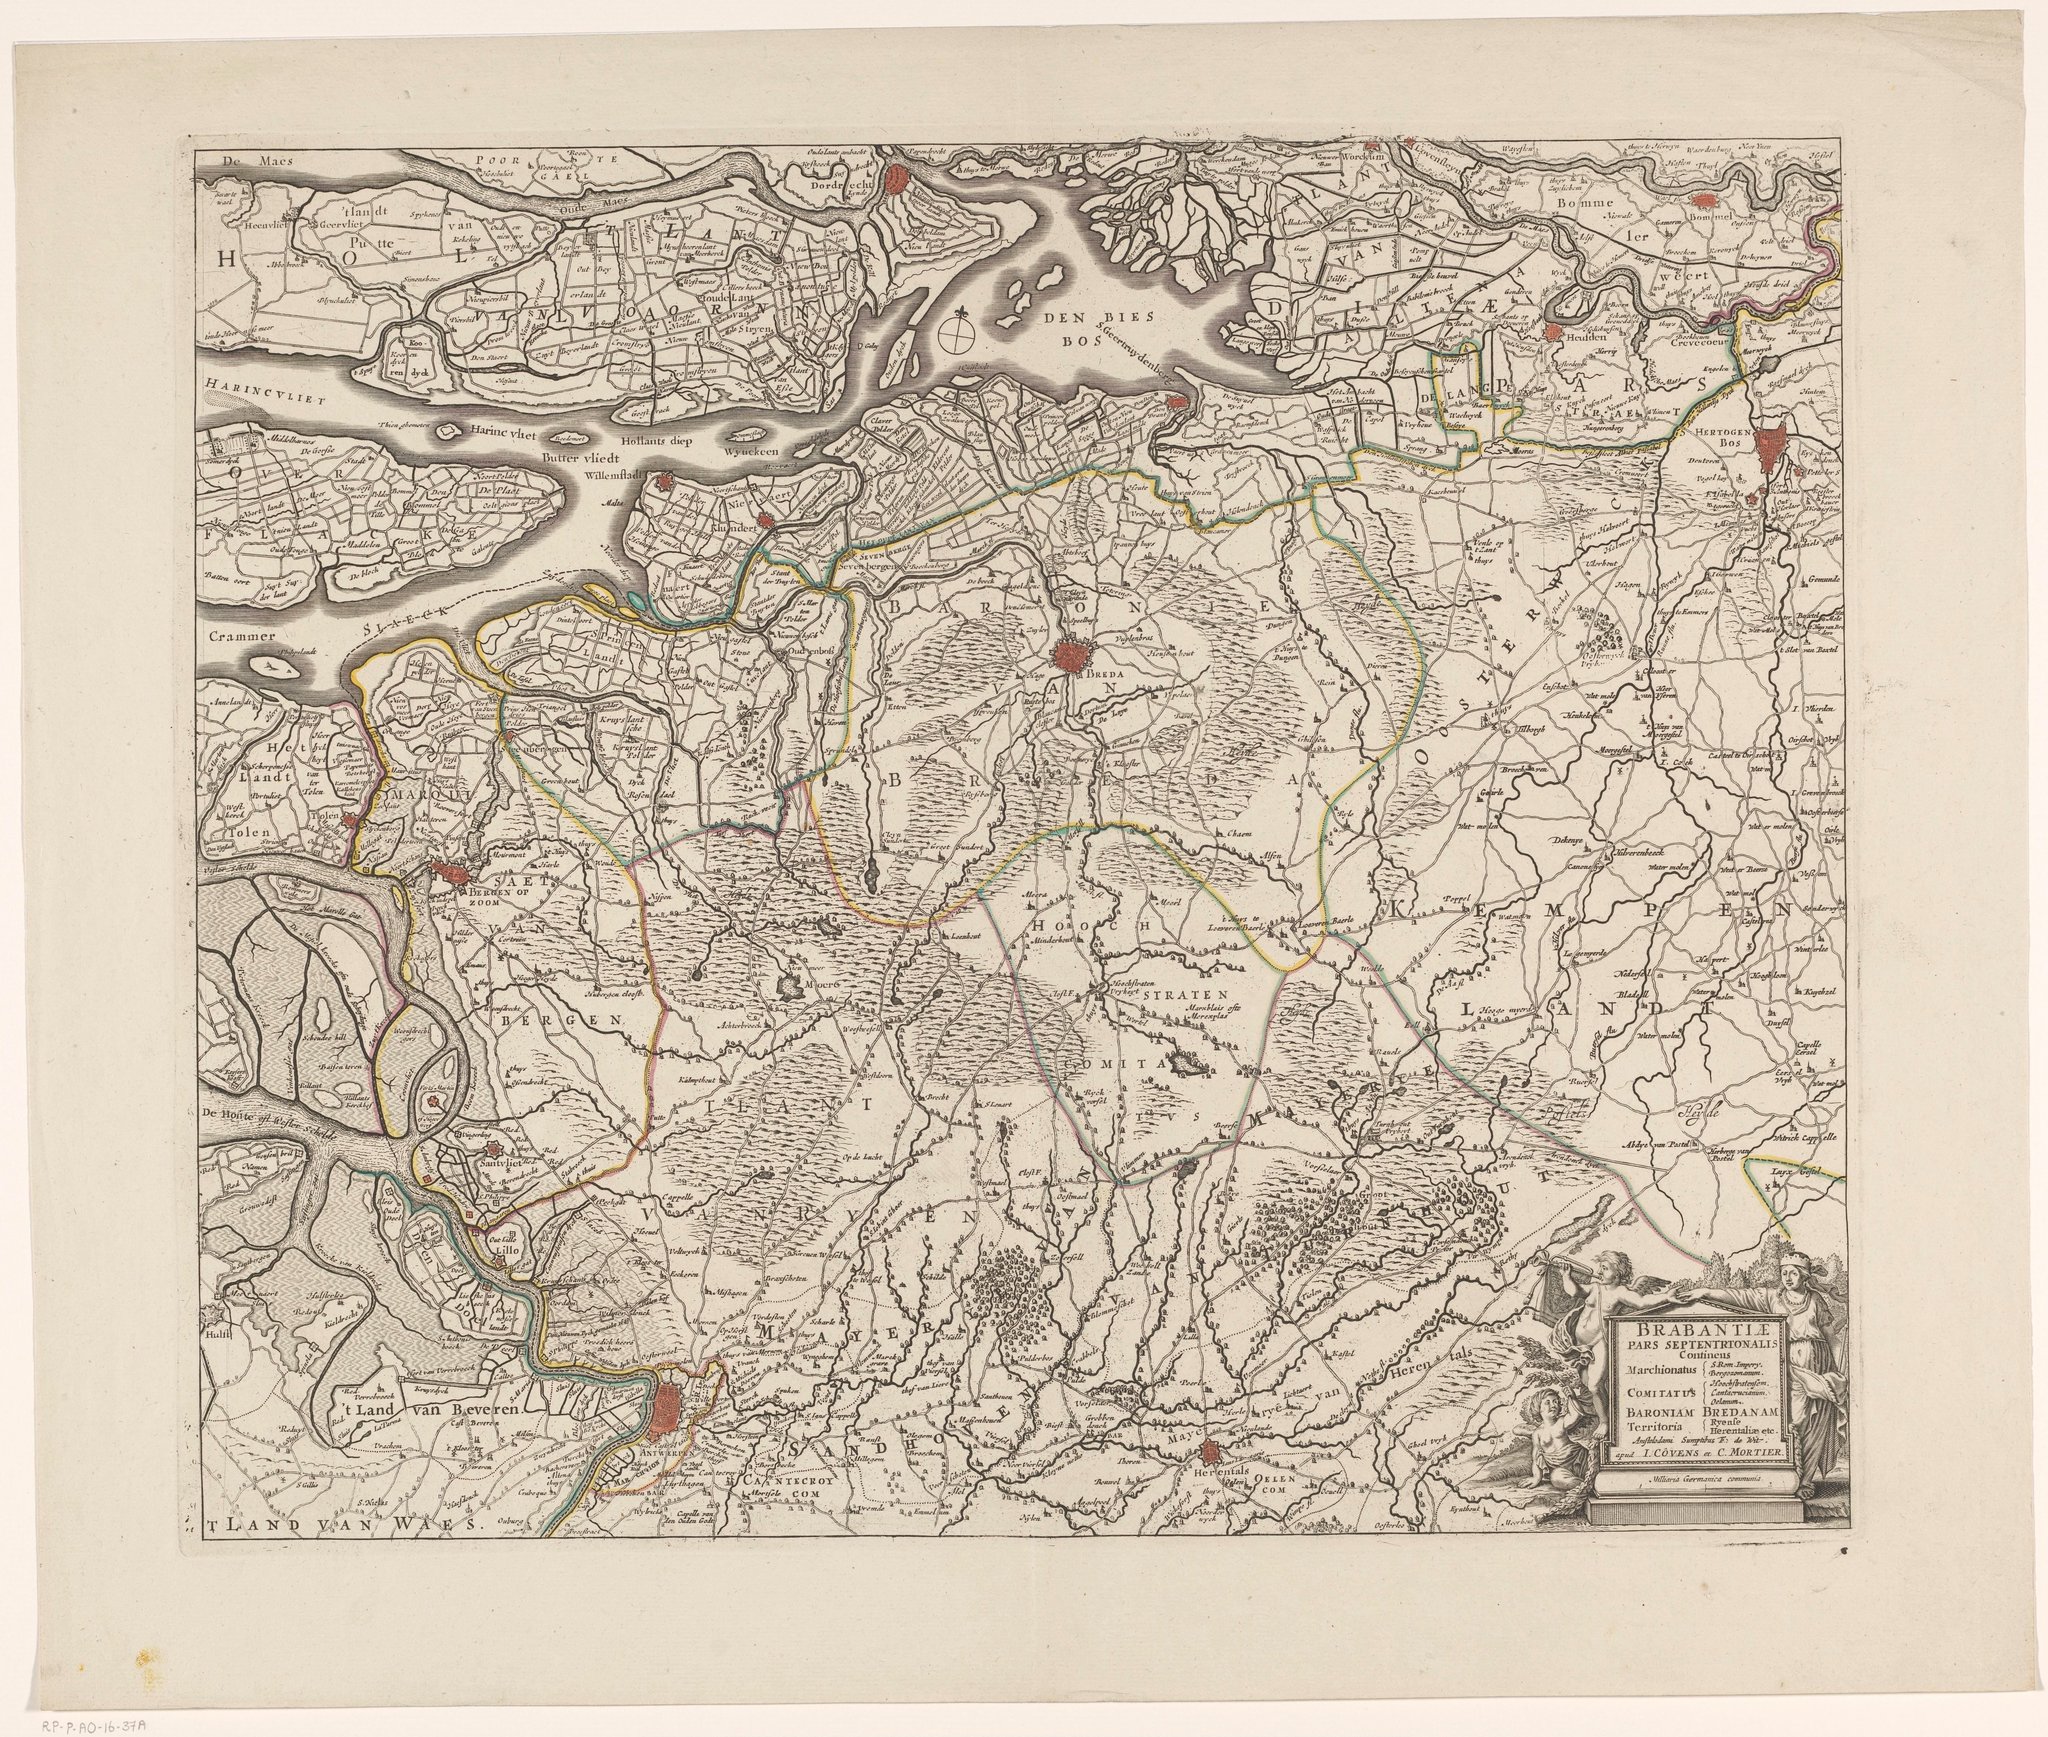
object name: print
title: Brabantiae pars septentrionalis continens Marchionatus (...)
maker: Anonymous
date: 1633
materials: paper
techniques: engraving, etching, hand coloring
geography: amsterdam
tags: maps of separate countries or regions, den bosch, antwerp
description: Kaart van het noordwestelijk deel van Brabant, waarin verschillende bestuurlijke gebieden in kleur zijn omlijnd. Rechtsonder de titelcartouche met schaalstok: 2 Milliaria Germanica communia.